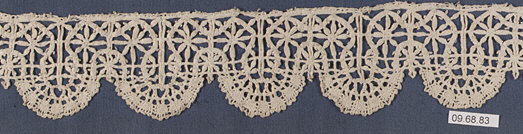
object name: edging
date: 1601-1633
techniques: lace